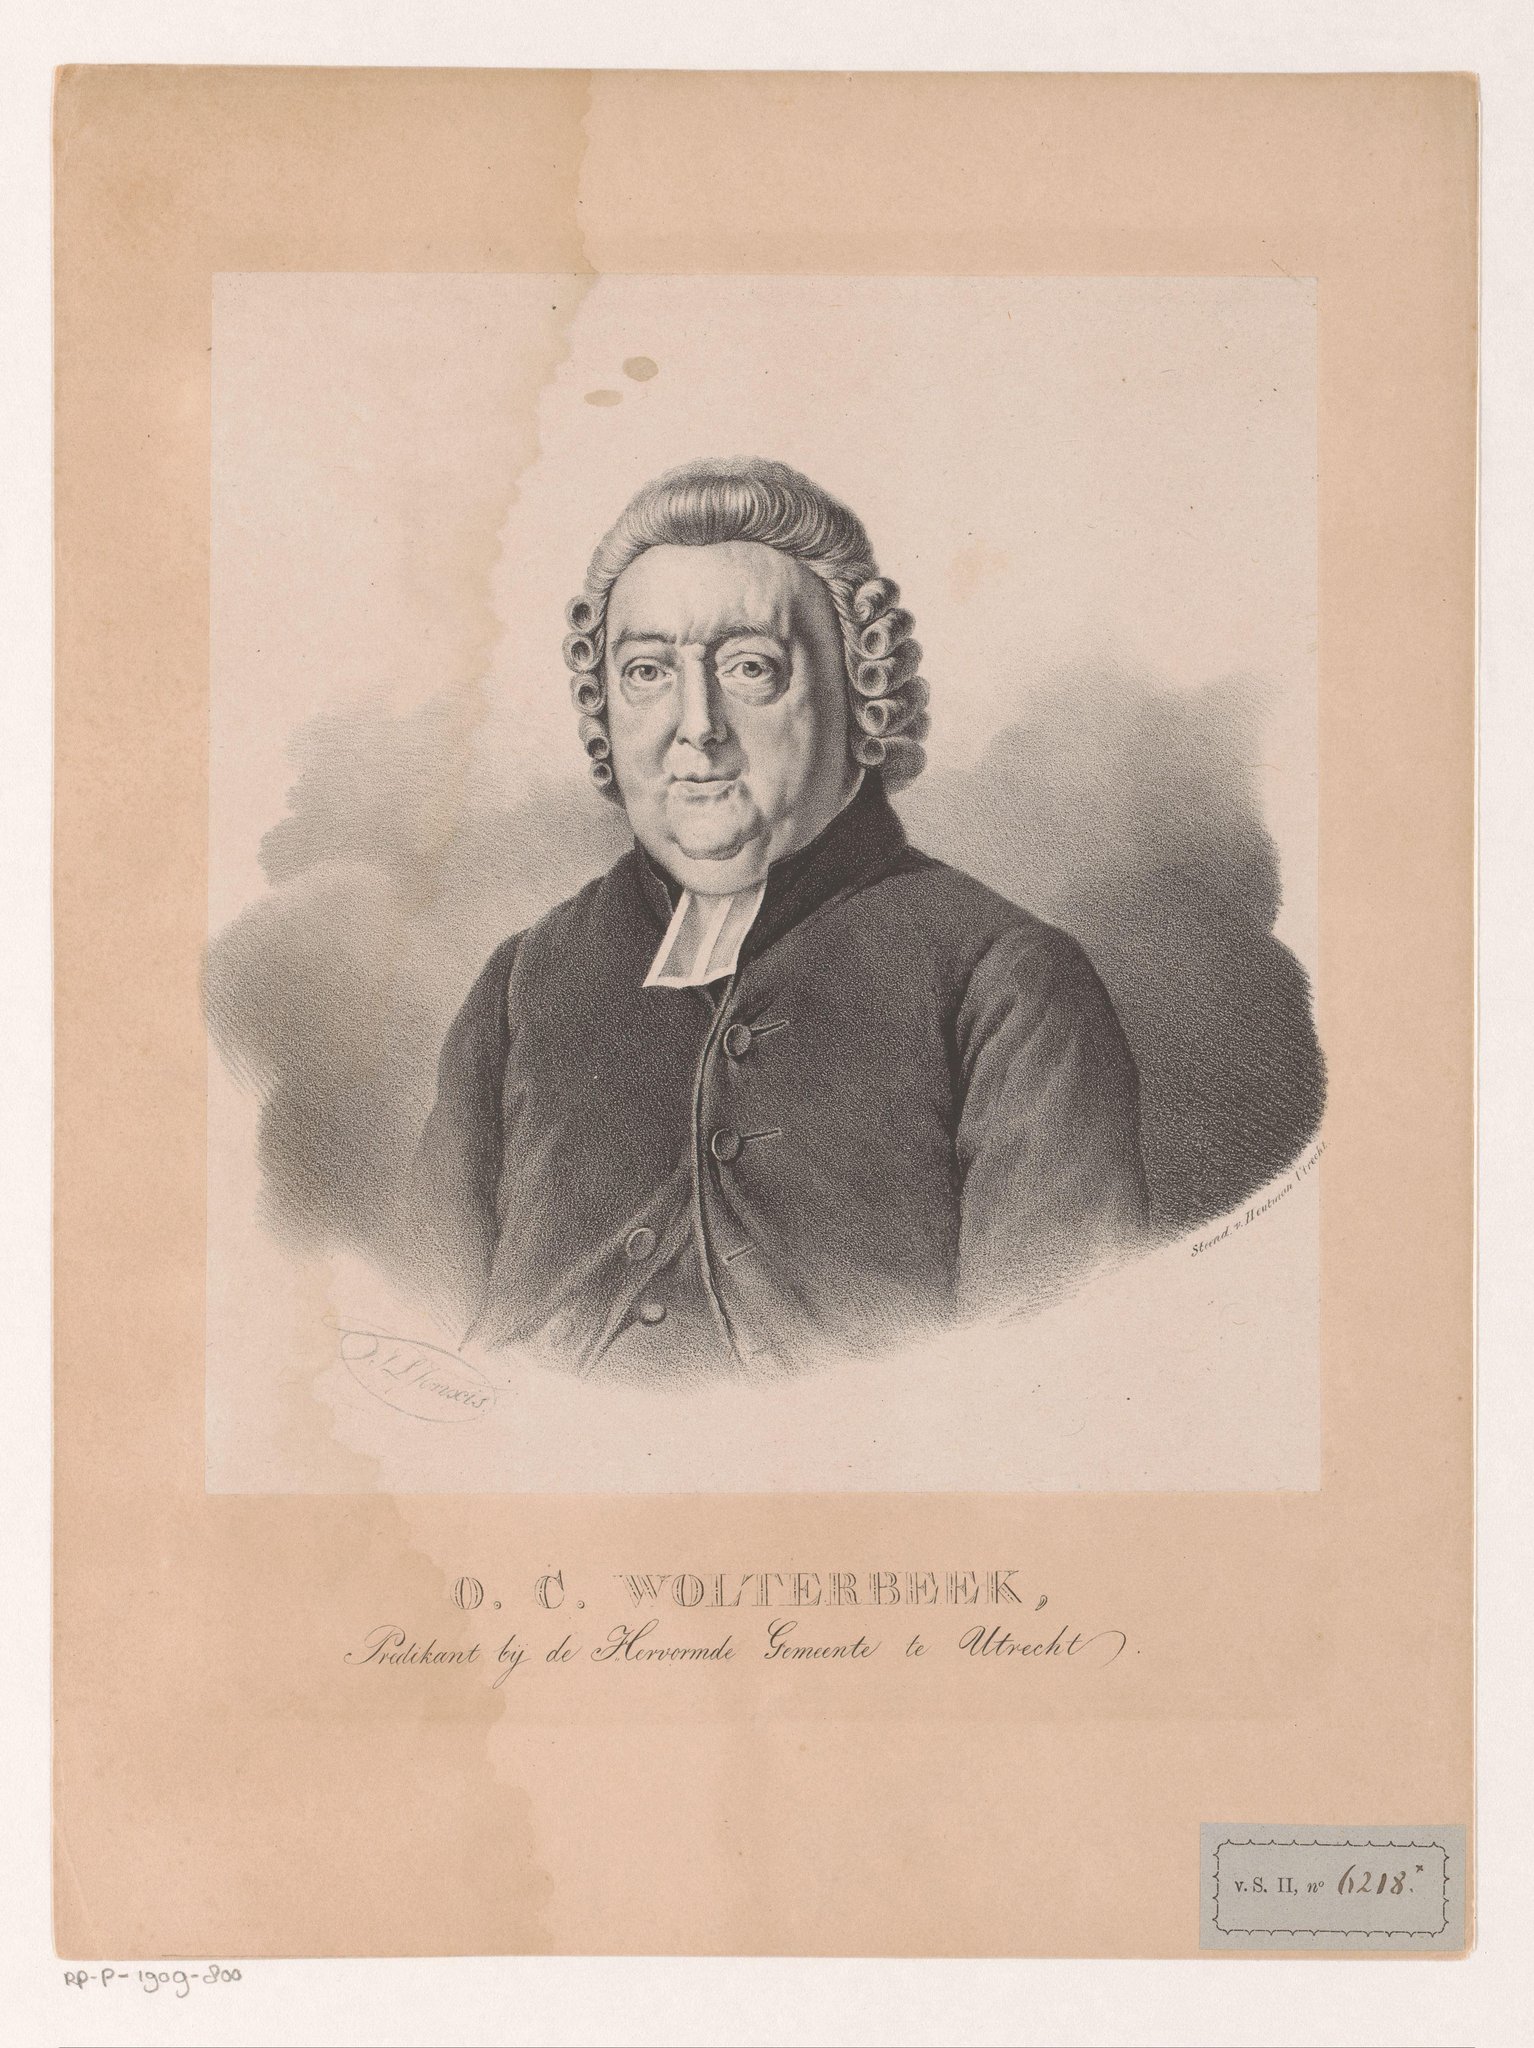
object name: print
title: Portret van Otto Coenraad Wolterbeek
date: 1828-1843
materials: paper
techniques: lithograph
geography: utrecht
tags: historical persons (+ (full) bust portrait)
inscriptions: collector's mark: Lugt 2228